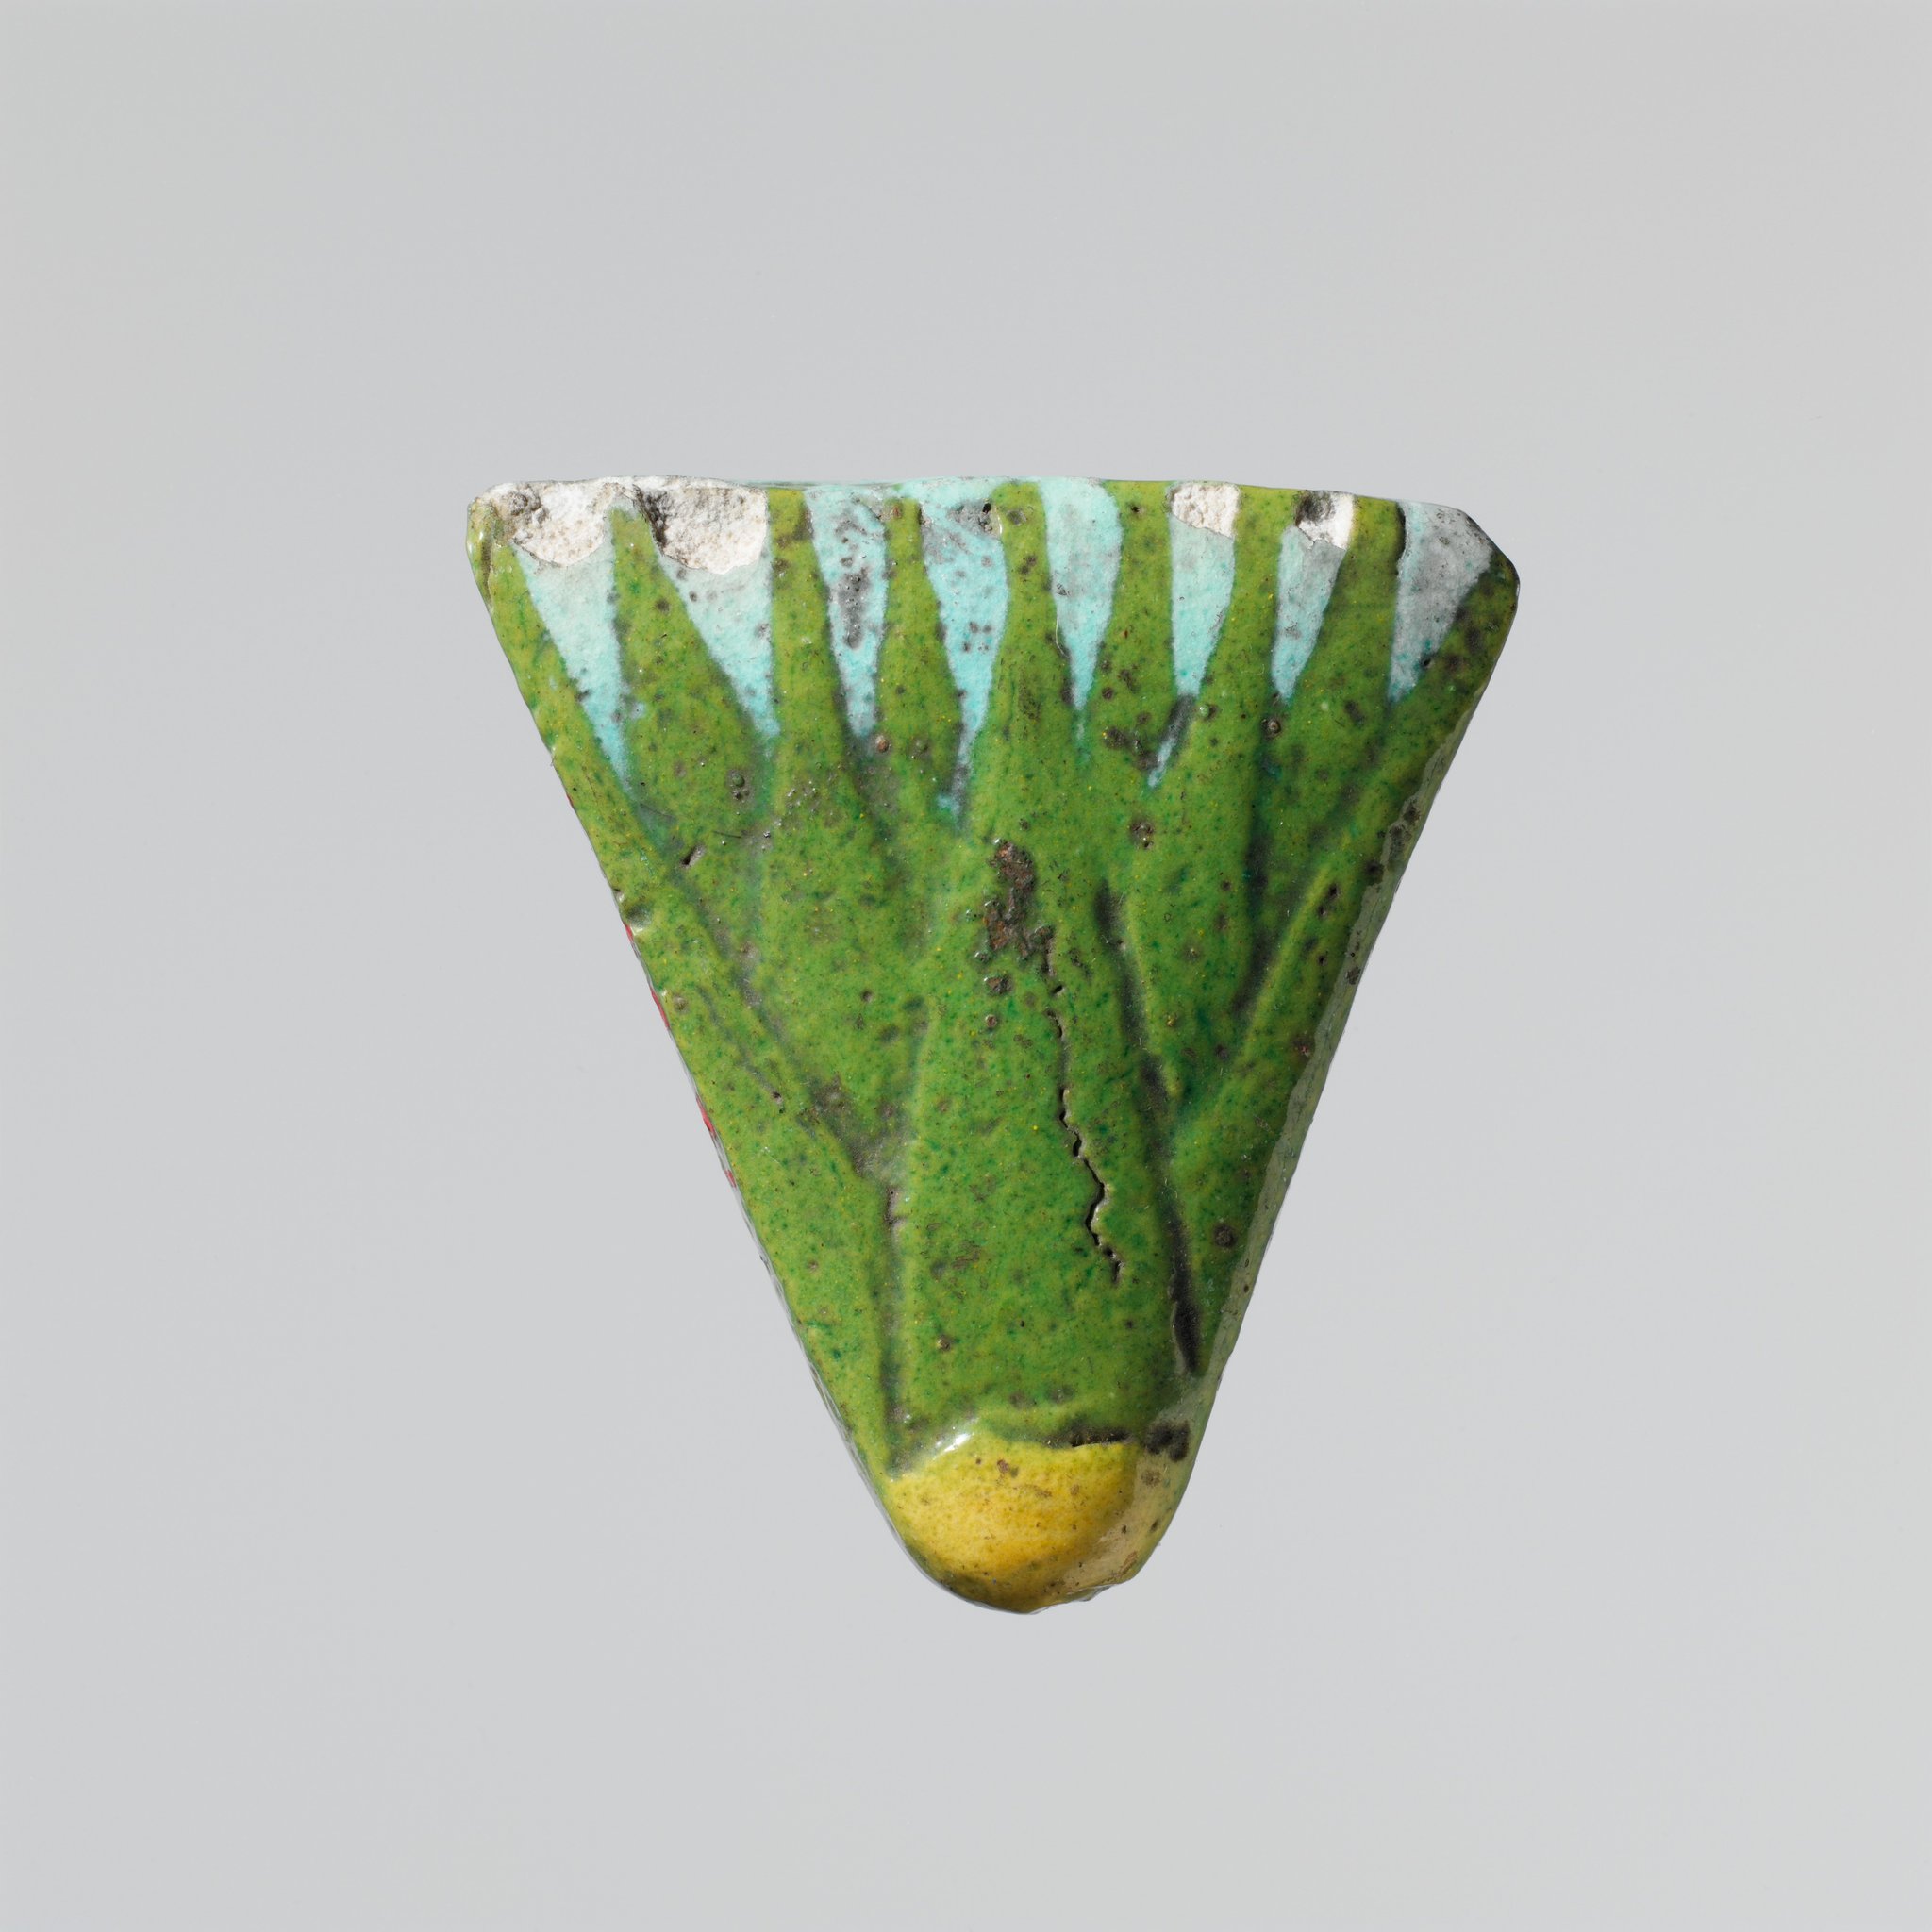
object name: inlay, lotus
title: Lotus inlay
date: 1400-1300 BCE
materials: faience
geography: egypt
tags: lotuses